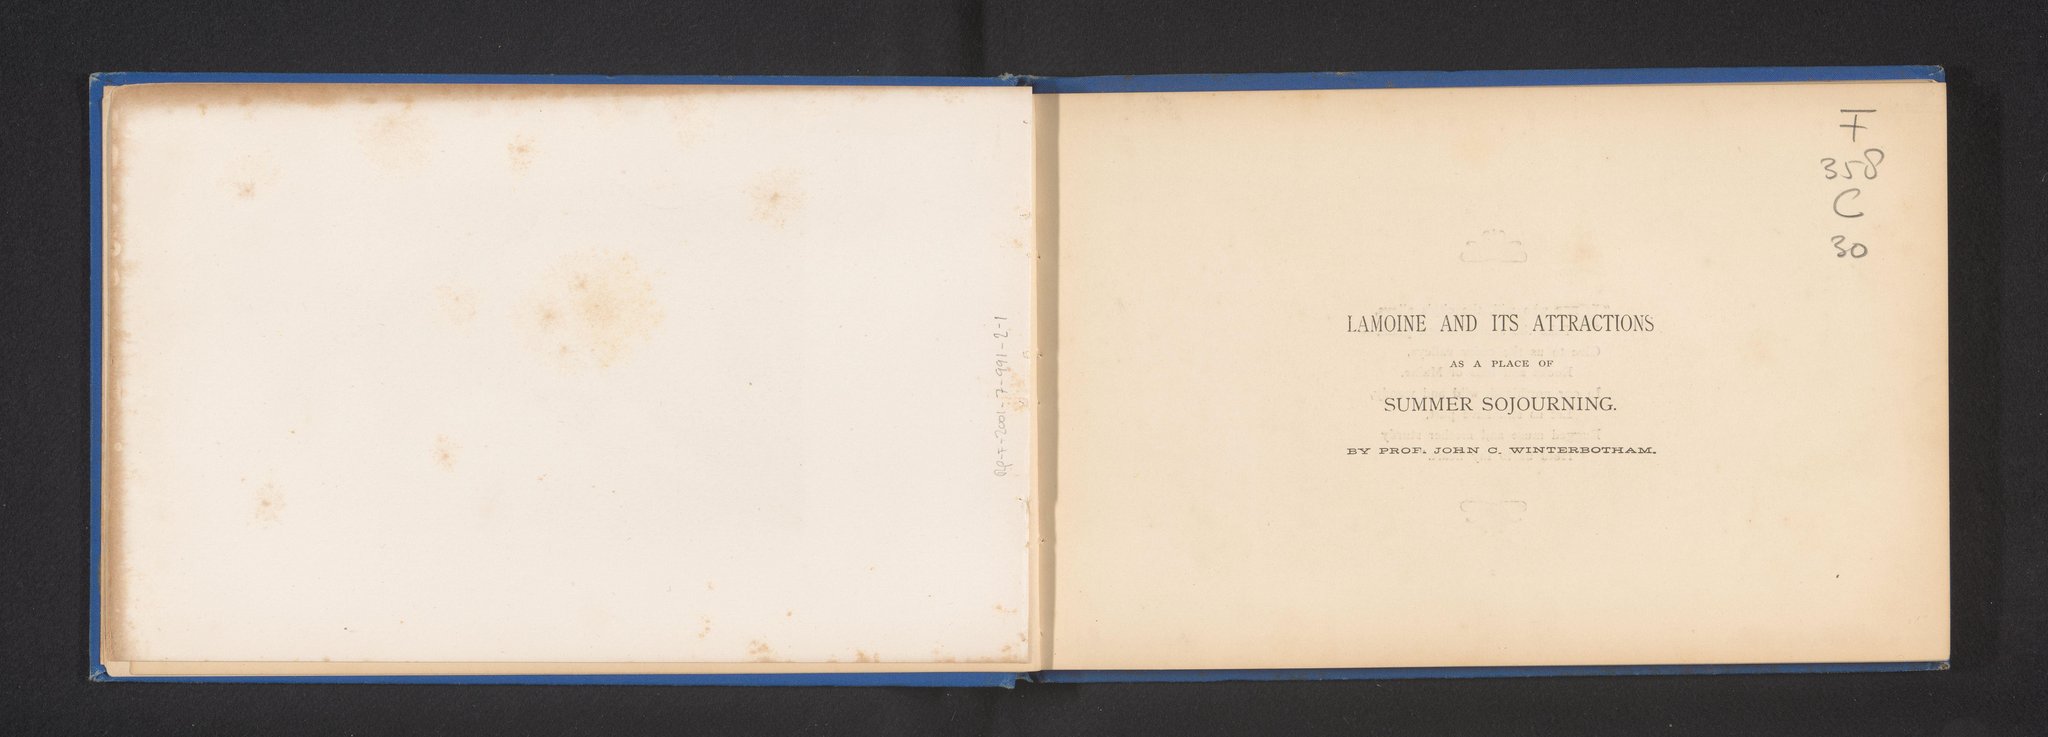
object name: book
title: Lamoine and its attraction as a place of summer sojourning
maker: john c. winterbotham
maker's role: professor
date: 1887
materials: linen, paper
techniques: photograph, printing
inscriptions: collector's mark: ‘From Magoon & Lewis, Bankers & Brokers, 7 &9 State st. Boston/ Stocks, bonds, grain, oil’, annotation: ‘Lamoine/ in 12 m. [...] Hancock Co/ South of [...]’, date: ‘June 1995’